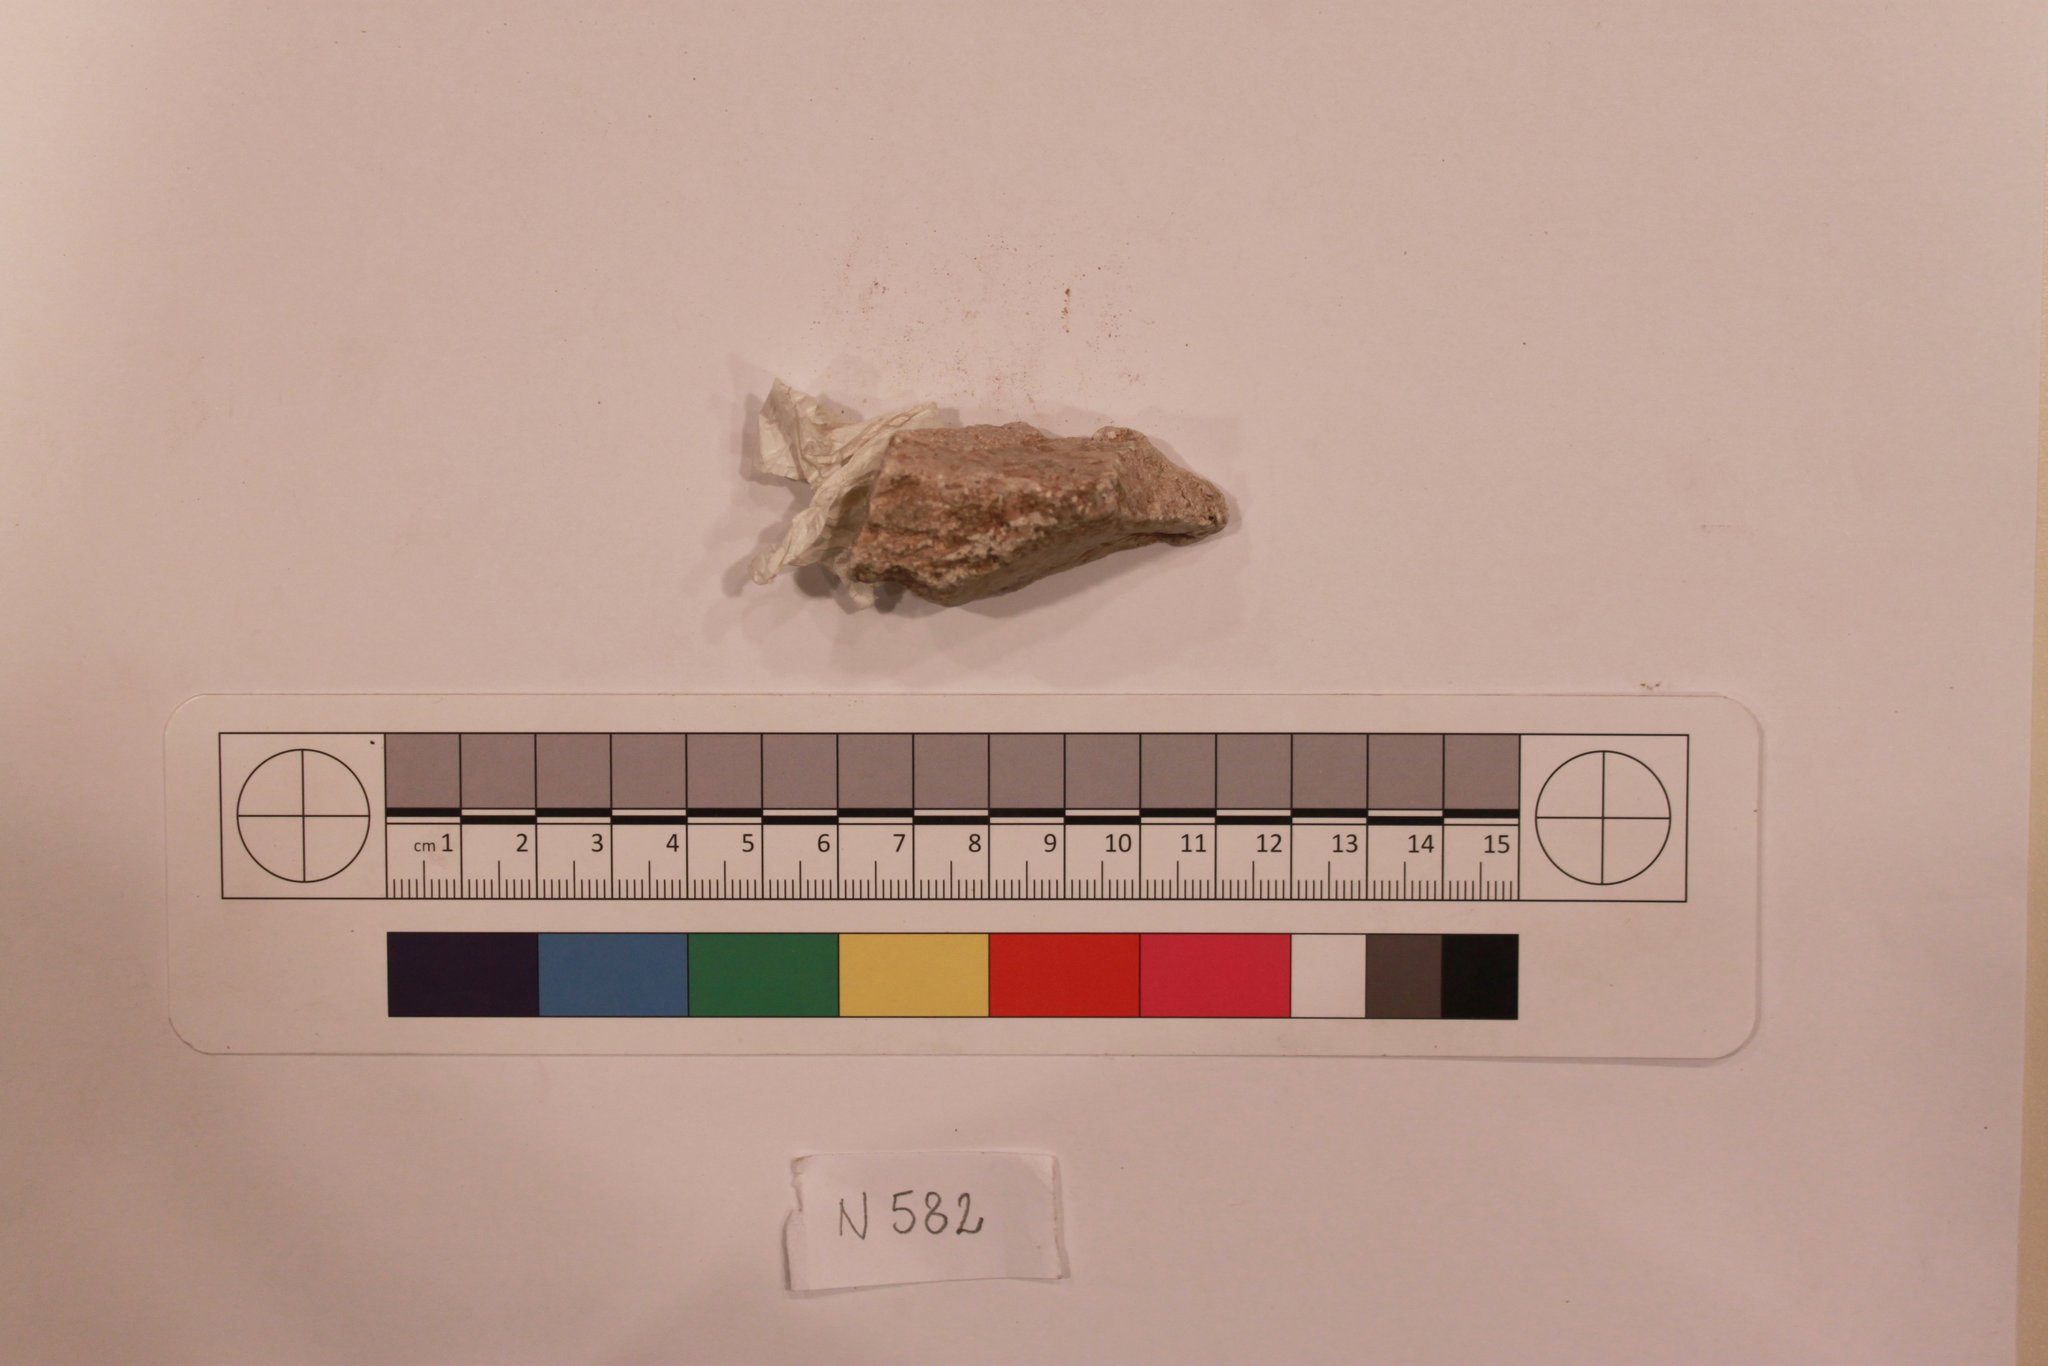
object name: fragment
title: Stucco Fragment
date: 701-1200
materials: plaster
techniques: carving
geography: iran